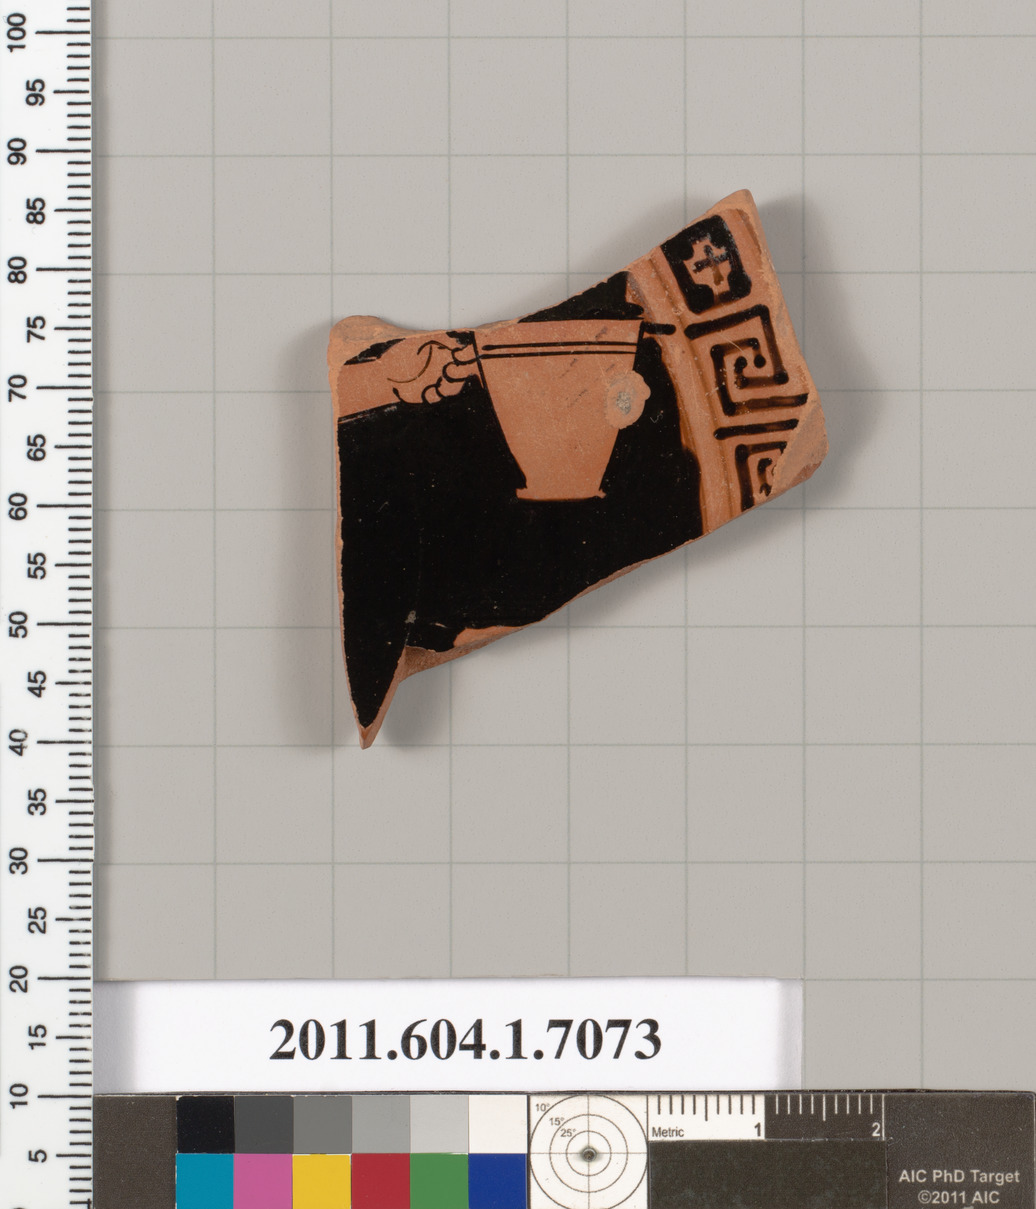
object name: kylix fragment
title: Terracotta fragment of a kylix (drinking cup)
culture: greek, attic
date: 500-480 BCE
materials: terracotta